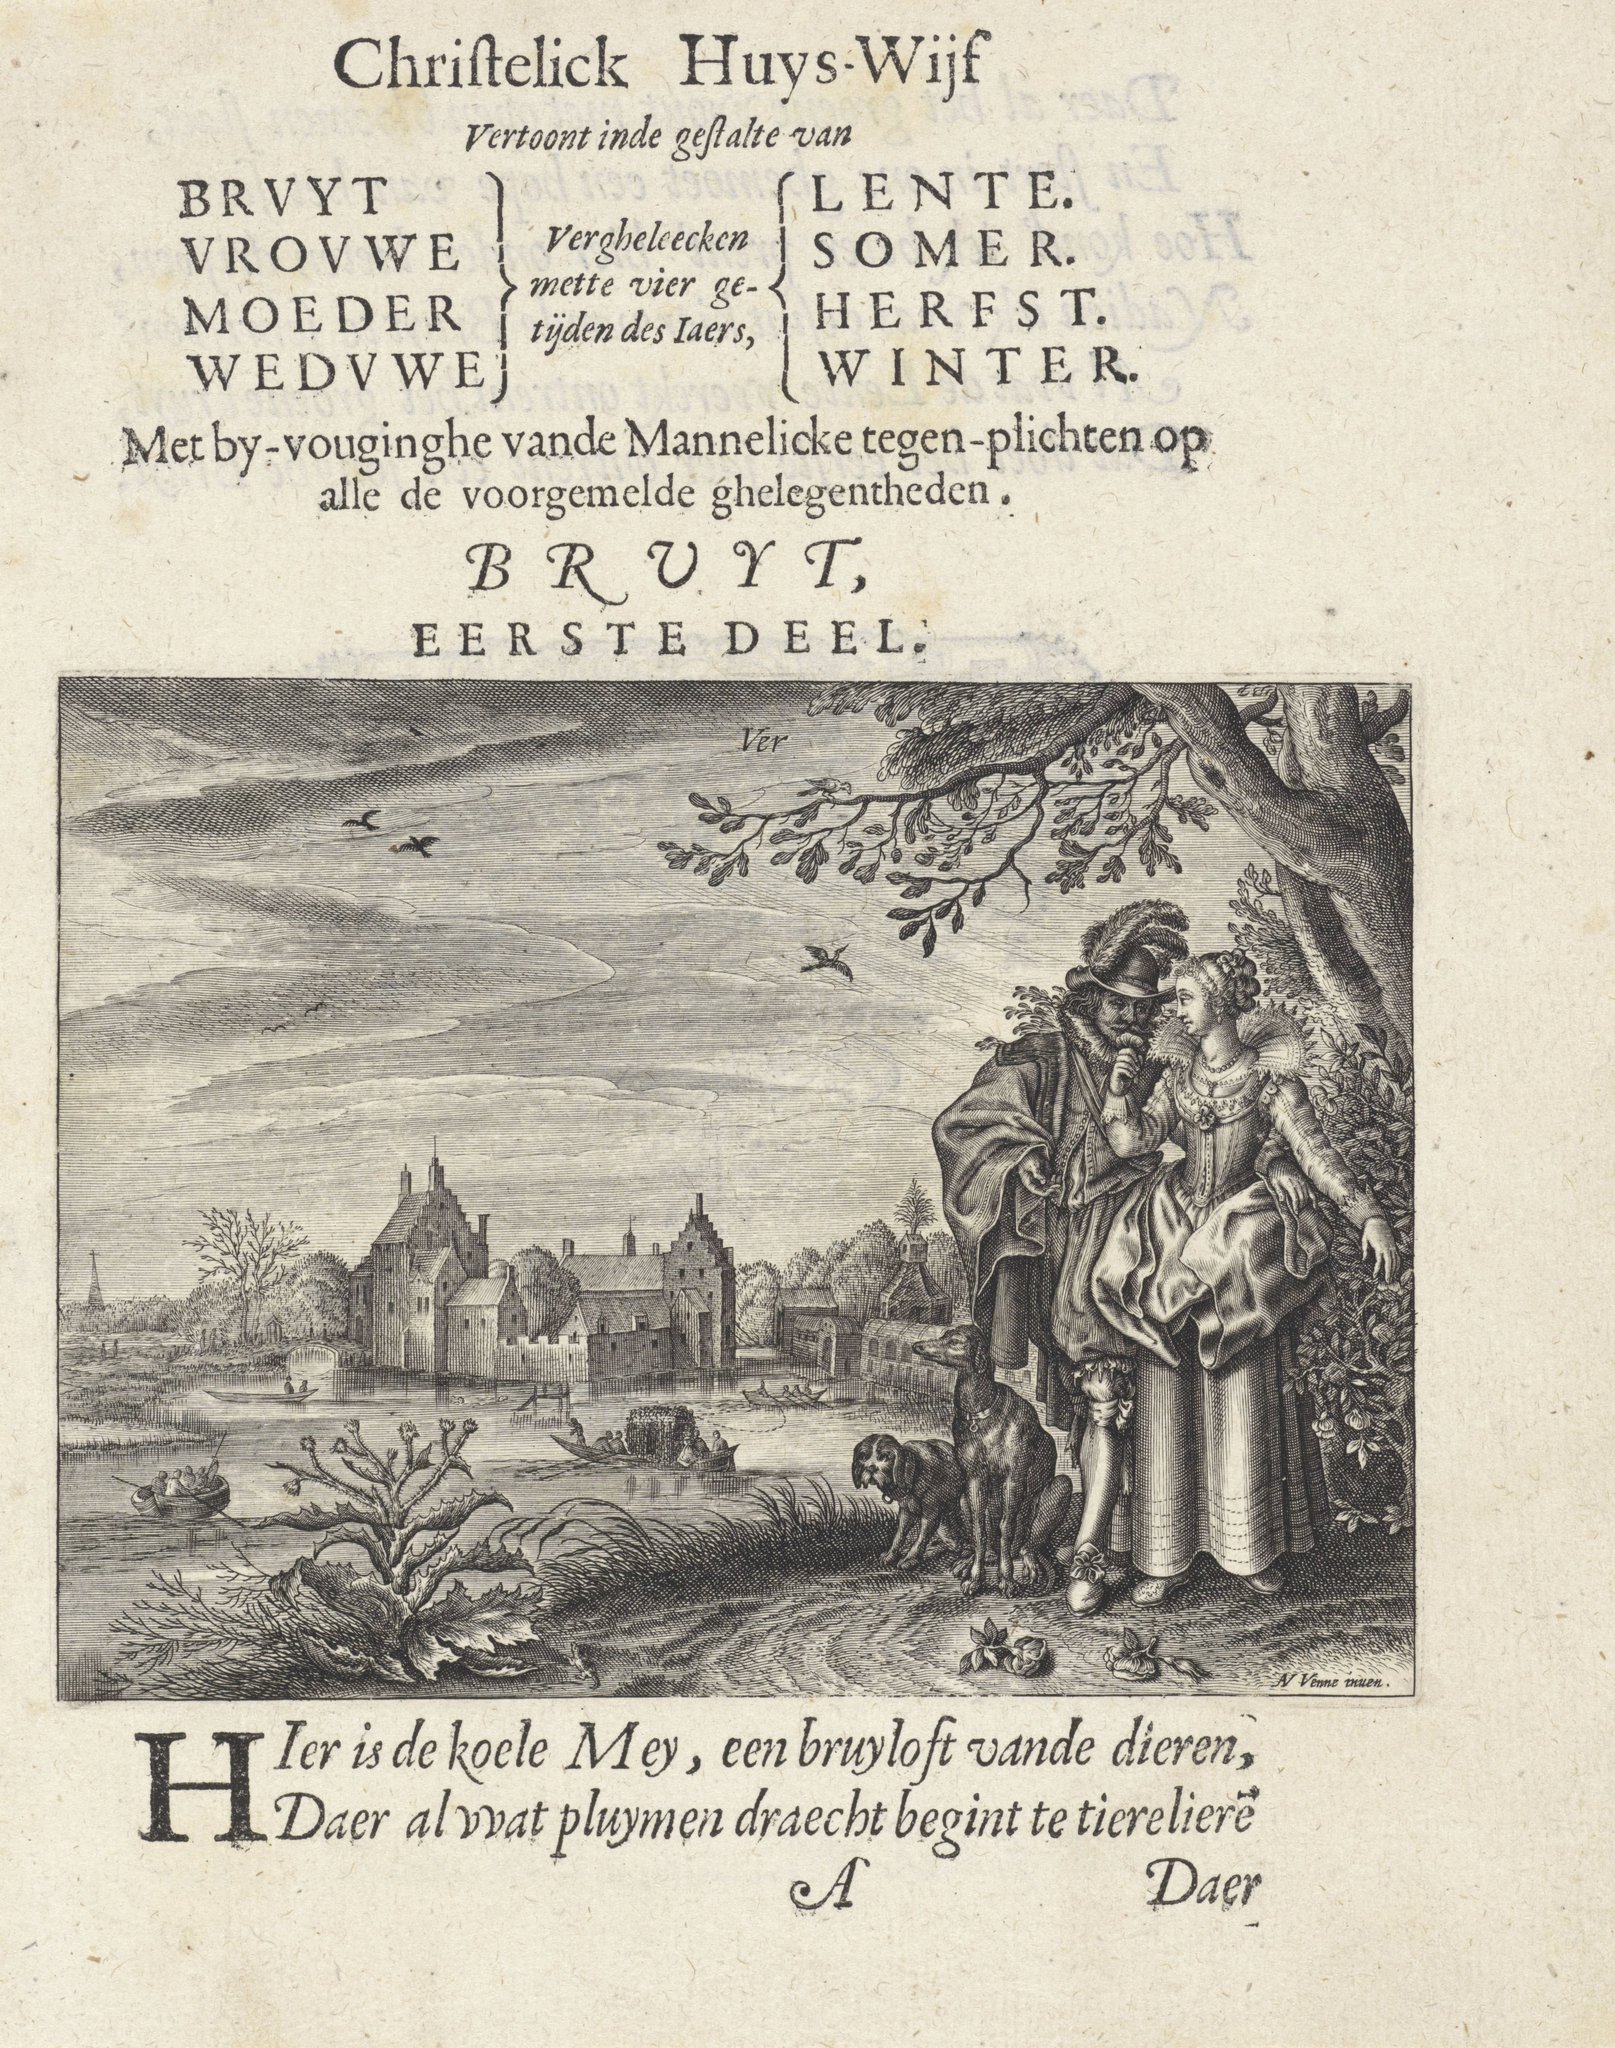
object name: print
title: Vrouw met bloem bij een man in een lentelandschap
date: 1625-1635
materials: paper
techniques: engraving, letterpress printing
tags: flowers, adolescent, young woman, maiden, castle, spring landscape; landscape symbolizing spring (the four seasons of the year), lovers; courting, flirting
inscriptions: collector's mark: Lugt 2760, collector's mark: Lugt 2228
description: Een jonge vrouw laat een man aan een bloem ruiken die zij in haar hand houdt. Op de achtergrond plezierboten op een slotgracht bij een kasteel. Aan de voeten van het paar twee honden. De jonge vrouw, als bruid als het eerste stadium van een vrouwenleven, wordt hier vergeleken met het jaargetijde lente.